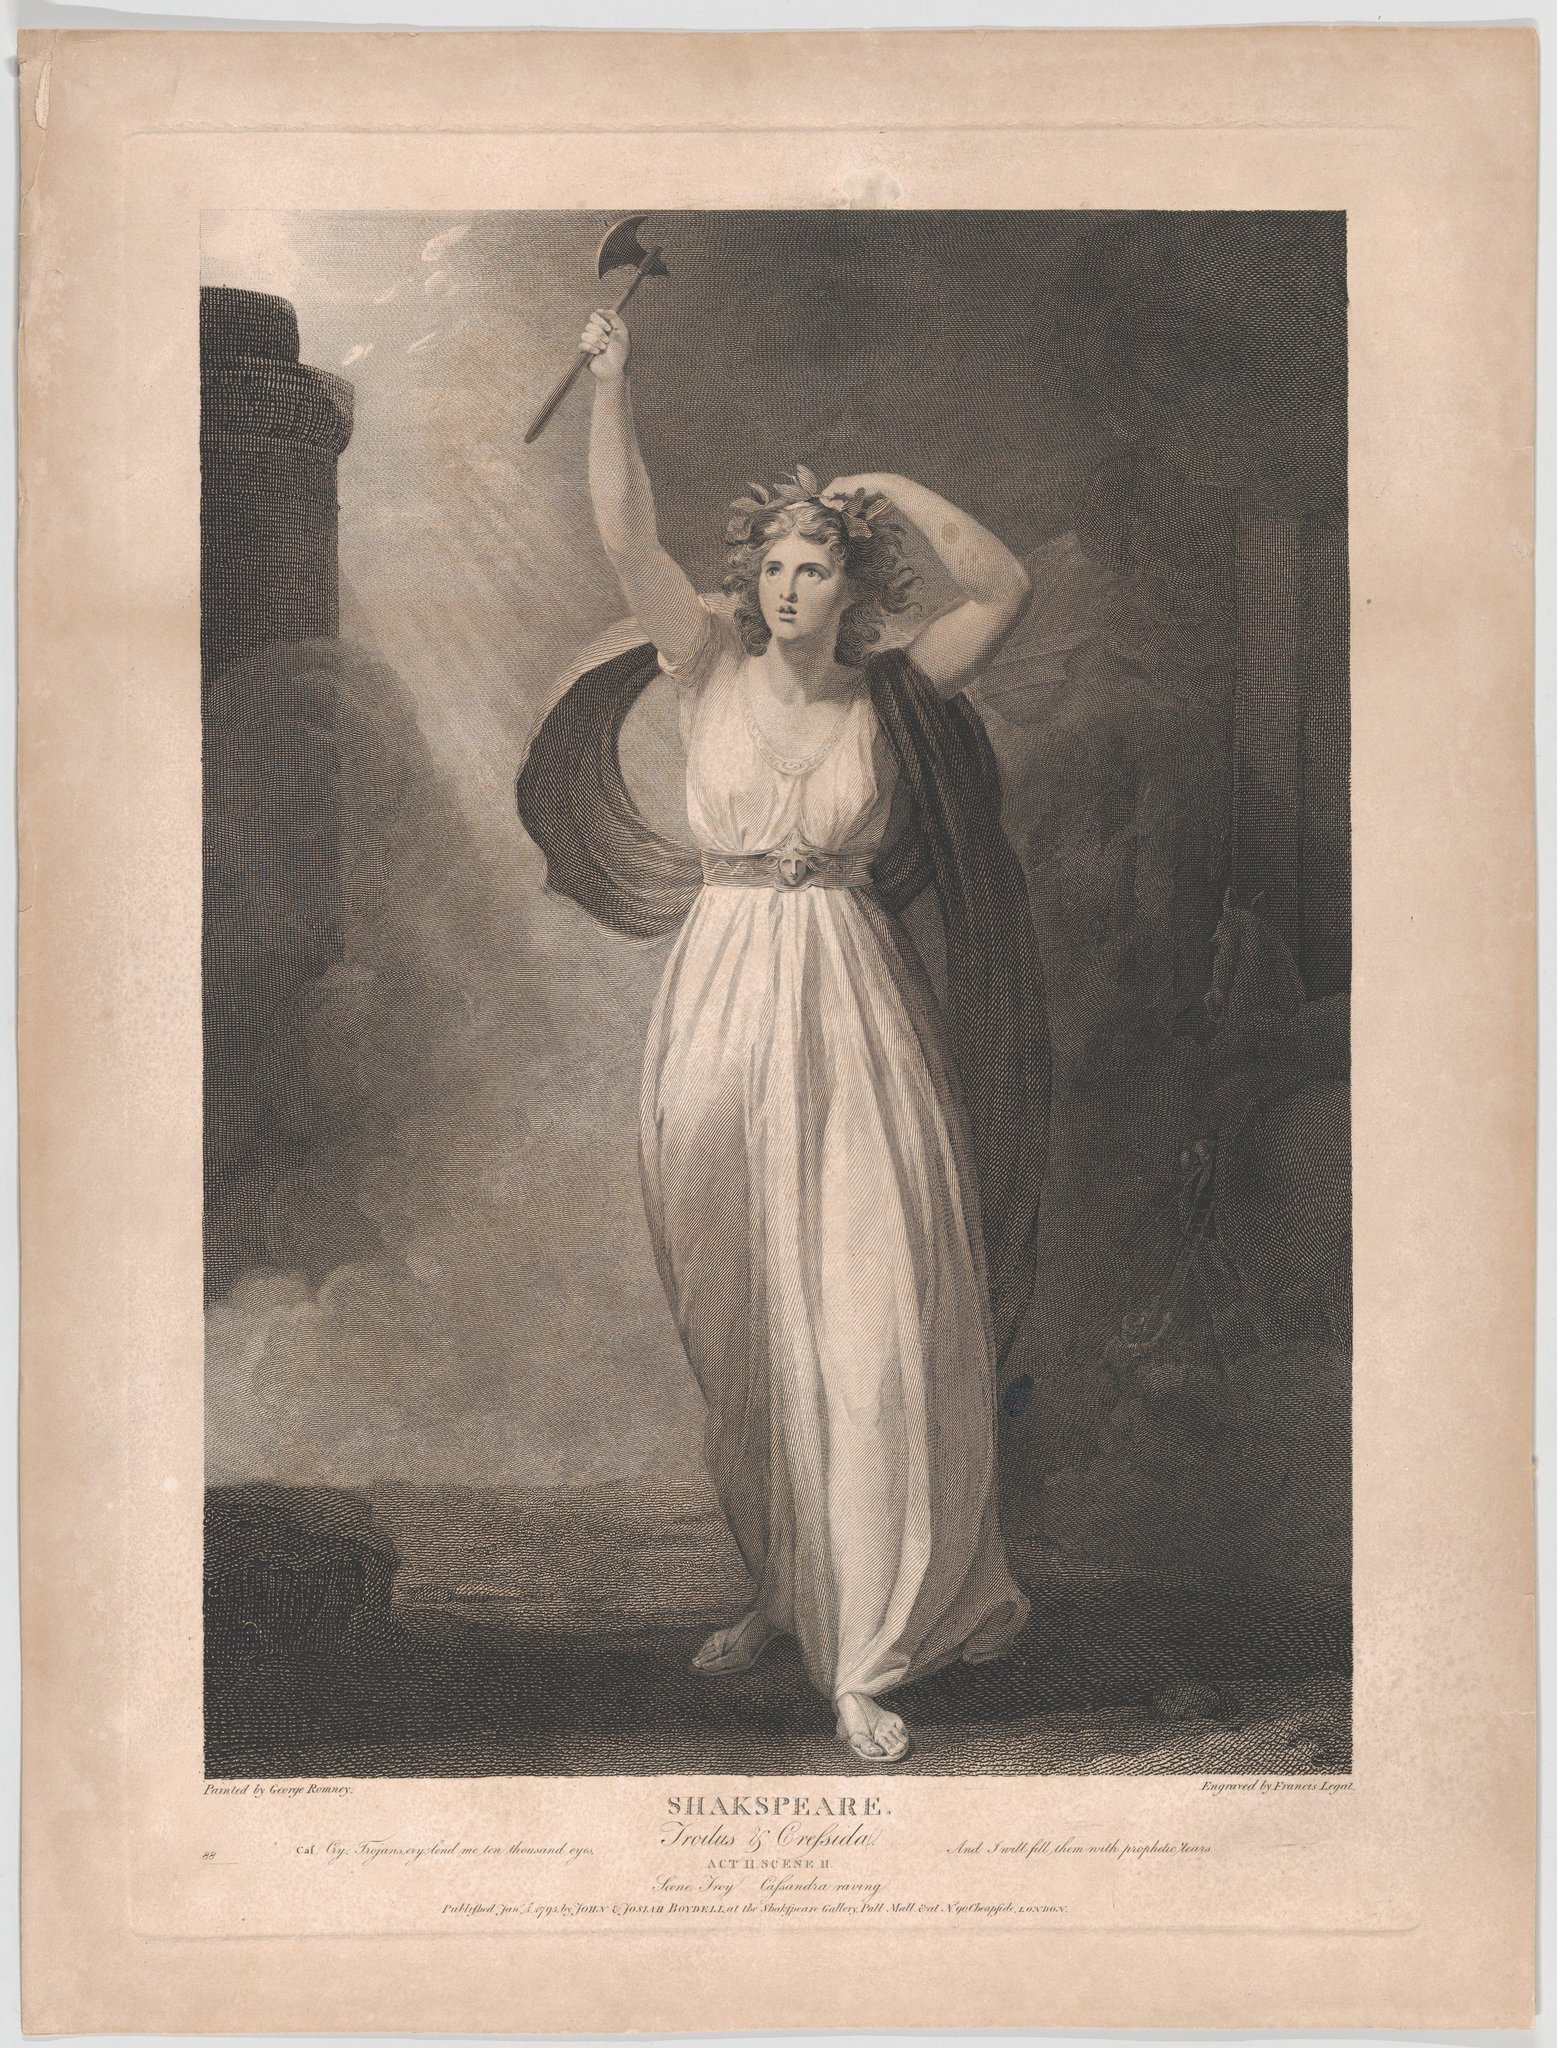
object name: print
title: Cassandra Raving (Shakespeare, Troilus and Cressida, Act 2, Scene 2)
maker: francis legat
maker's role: engraver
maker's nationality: british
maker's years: 1755-1809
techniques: engraving, etching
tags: shakespeare,women,axes